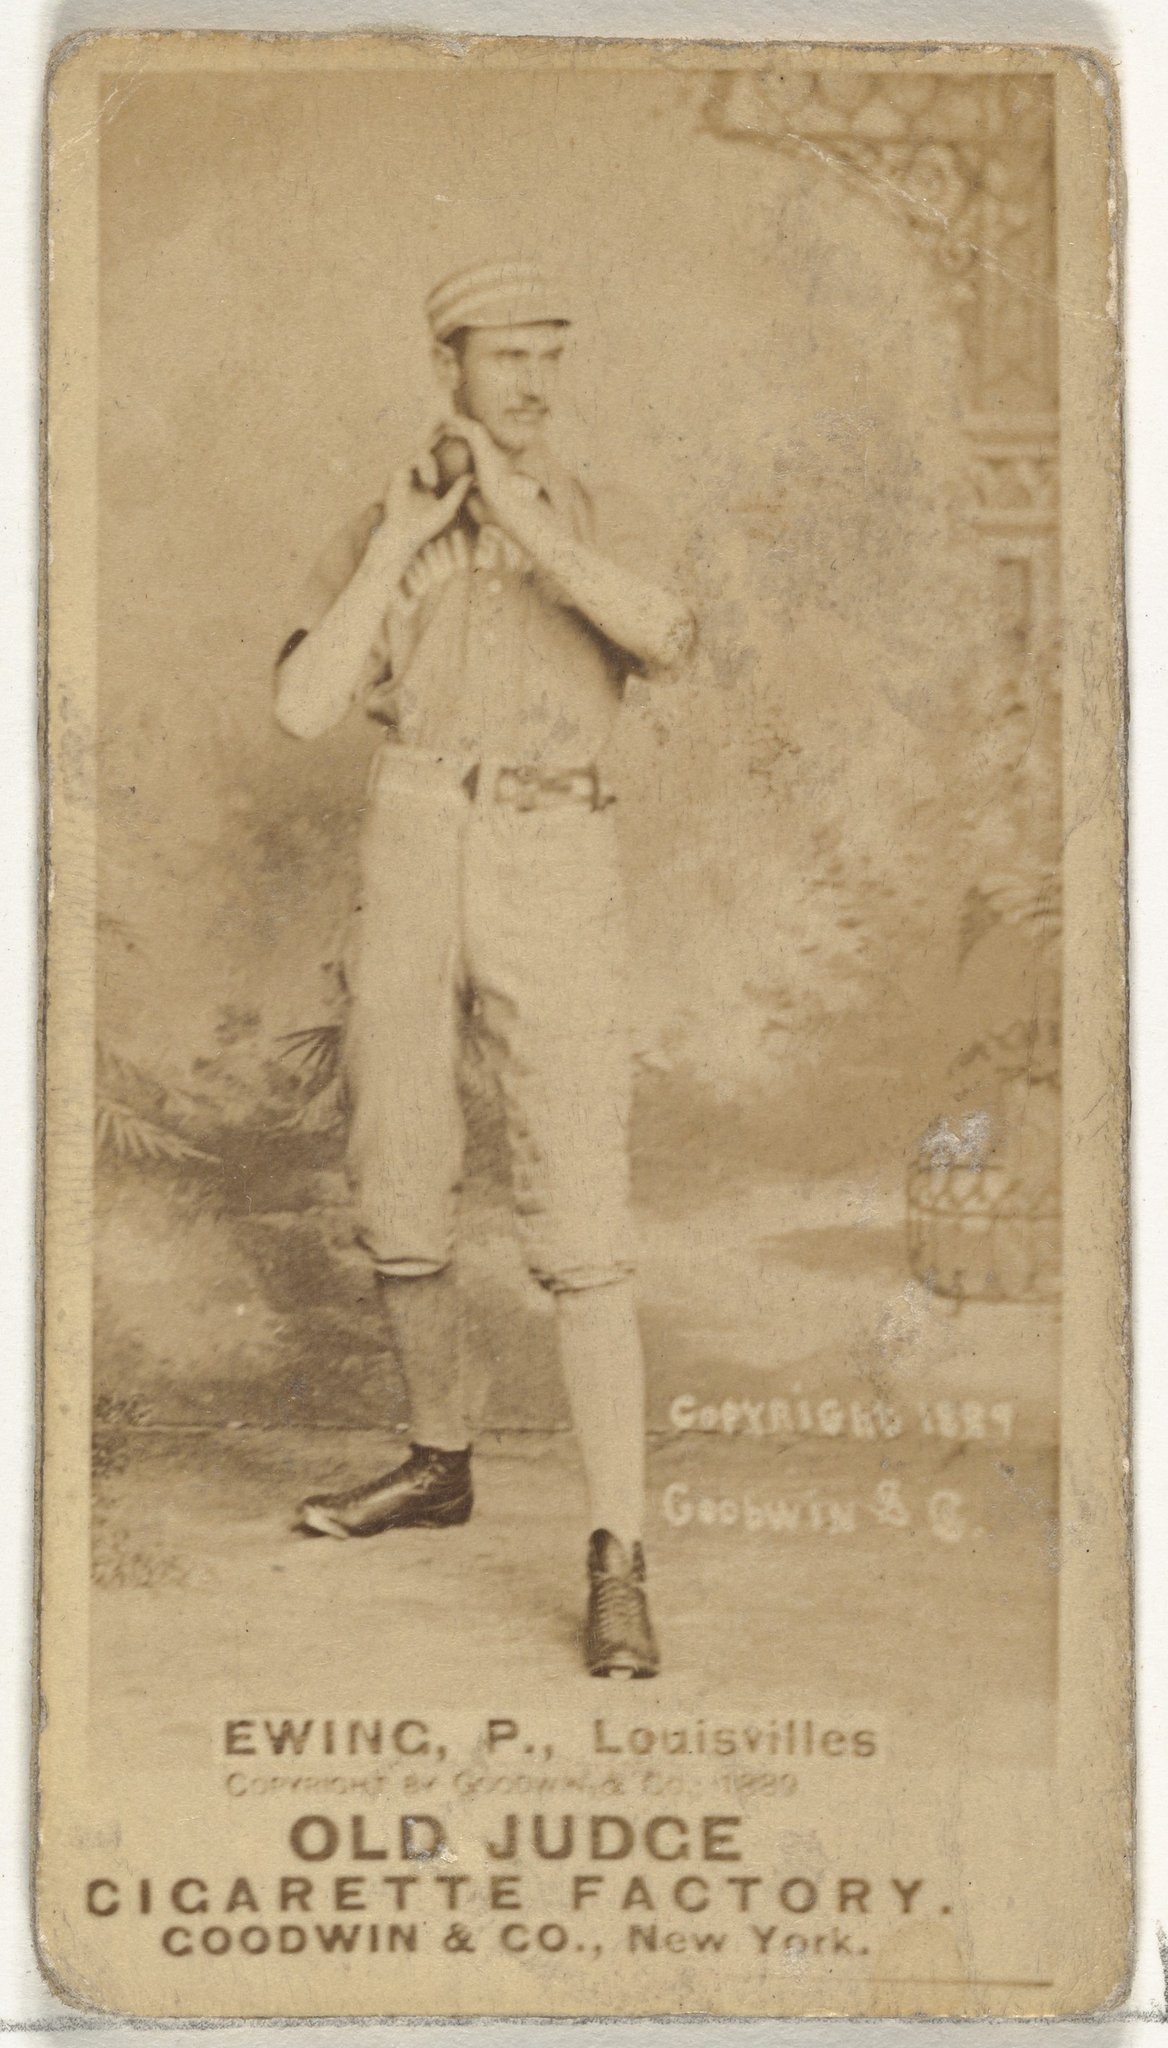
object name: baseball card, photograph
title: John Ewing, Pitcher, Louisville Colonels, from the Old Judge series (N172) for Old Judge Cigarettes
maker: goodwin & company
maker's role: publisher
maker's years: 1850-1950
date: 1889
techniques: albumen silver print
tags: men,portraits,baseball,athletes